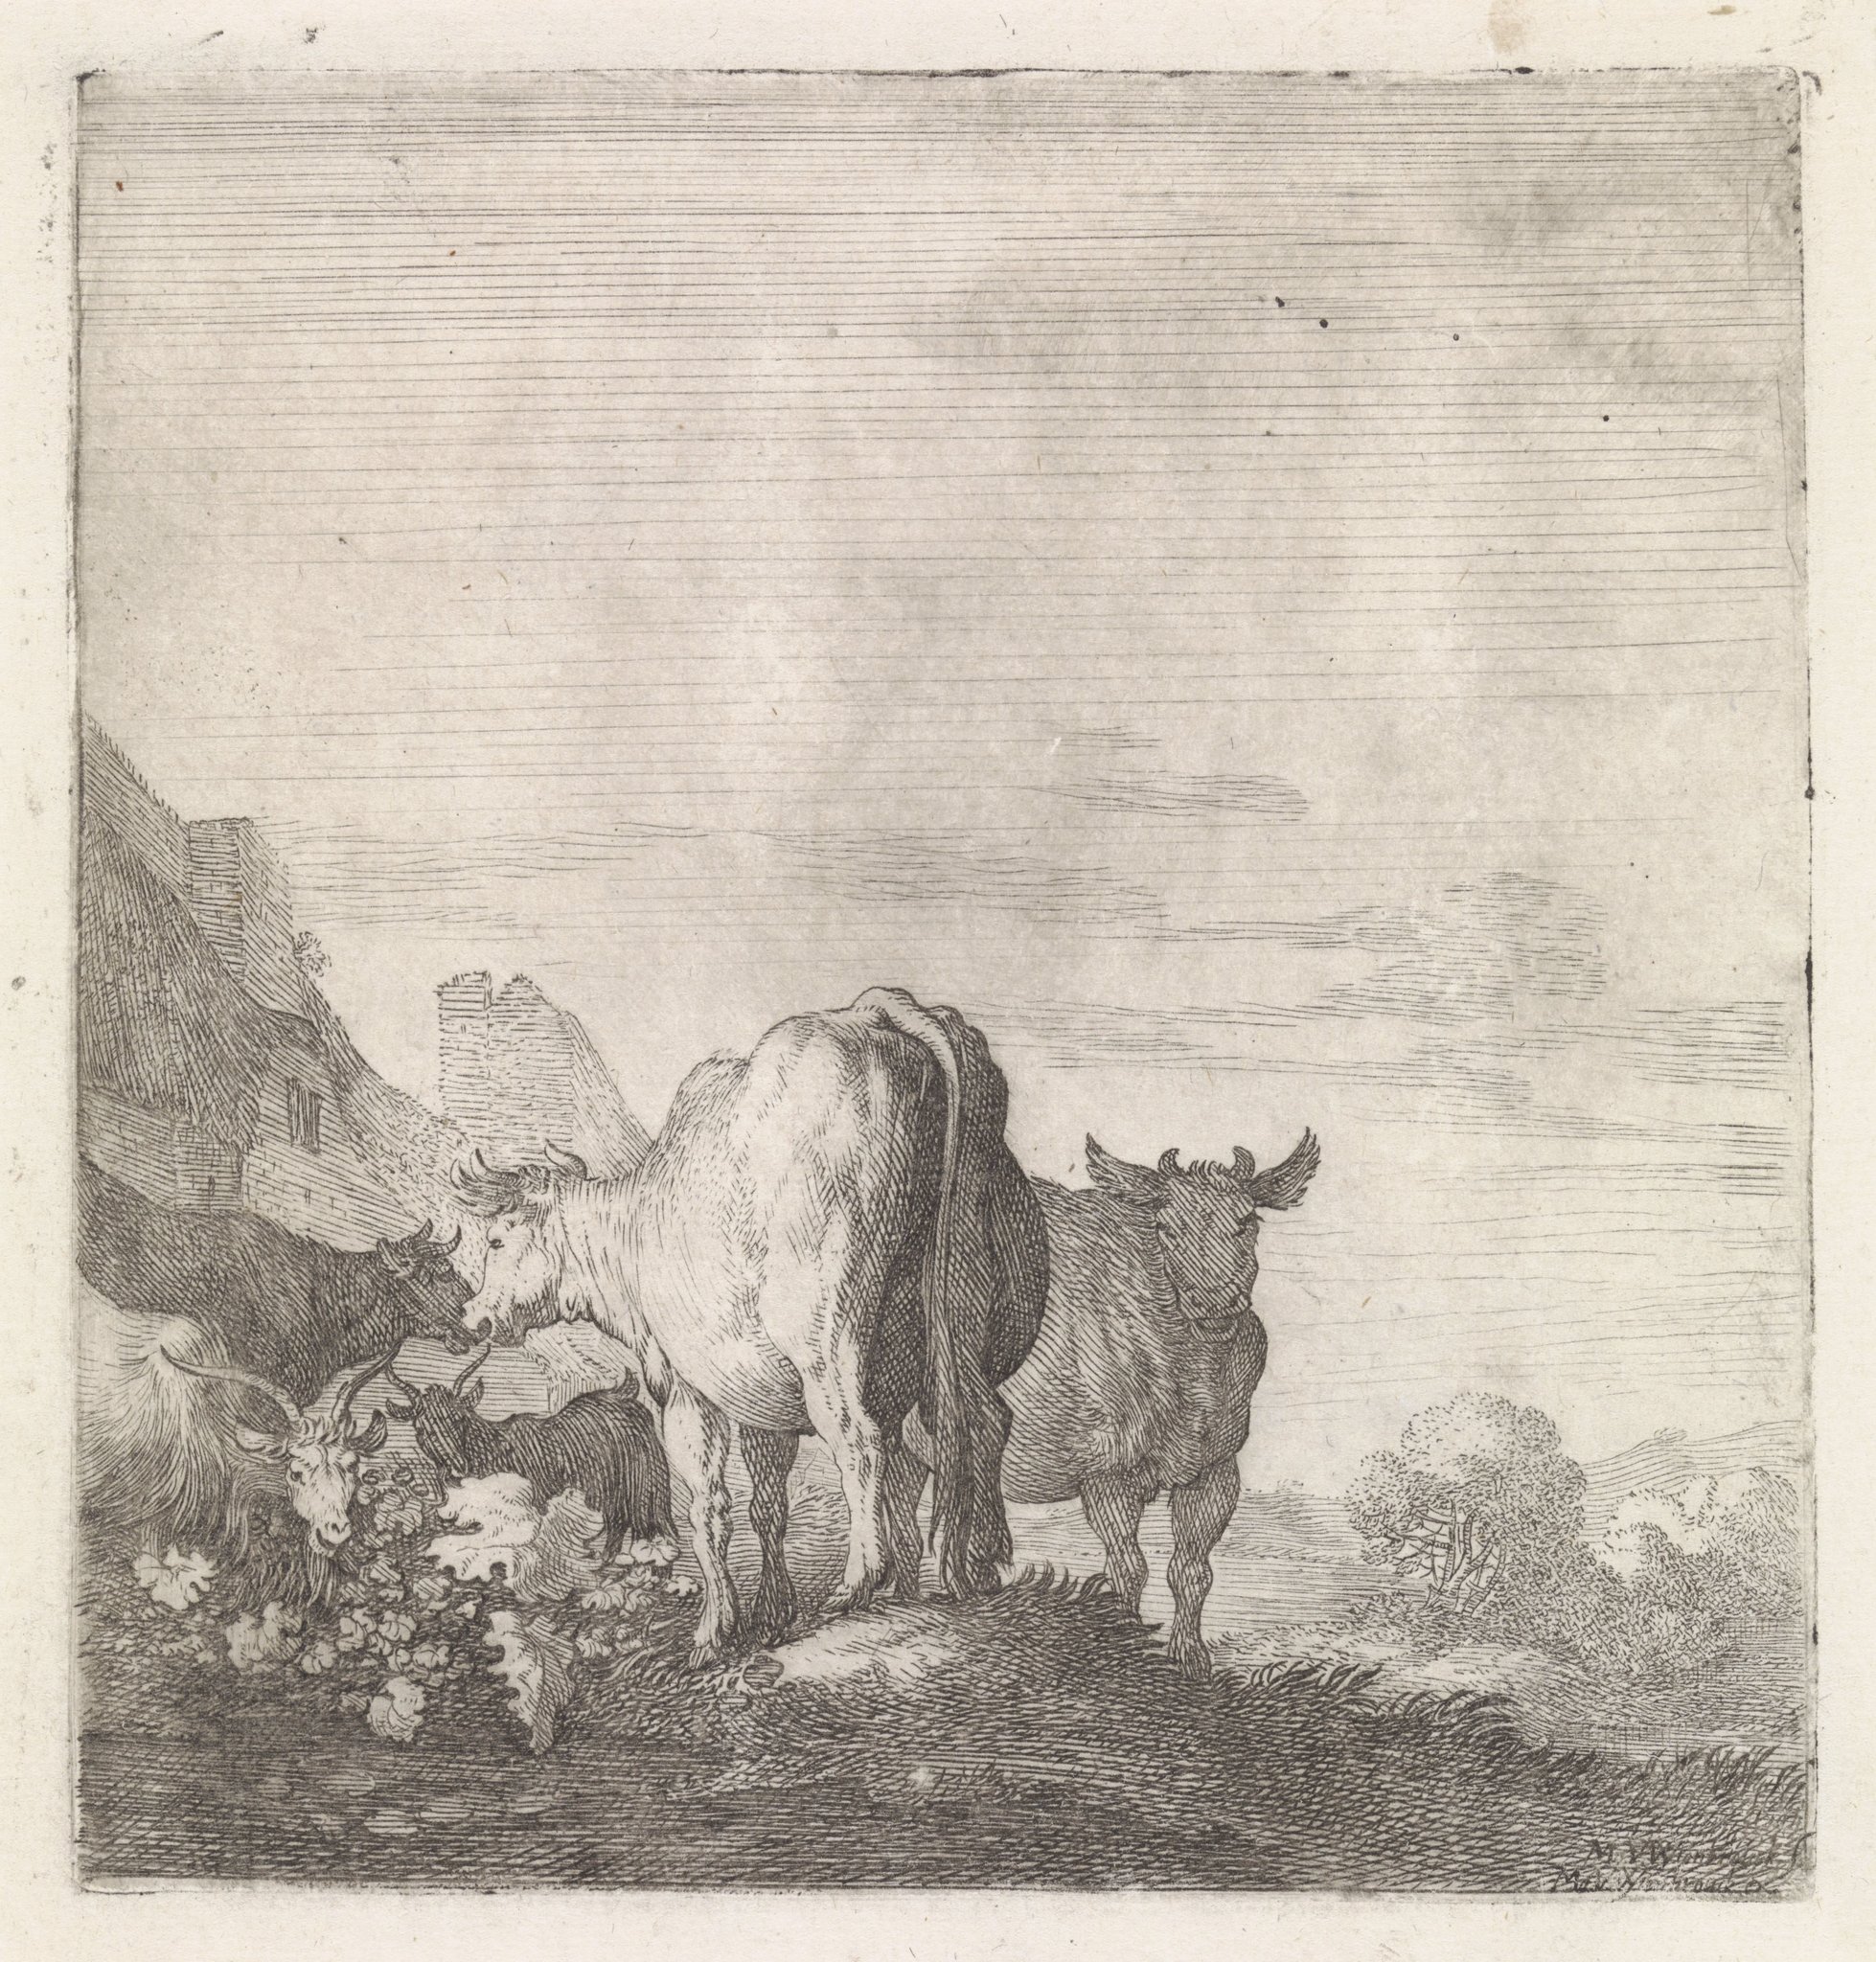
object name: print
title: Koeien en geiten in een landschap met huizen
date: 1600-1647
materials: paper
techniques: drypoint, engraving, etching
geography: the hague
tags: bovine cattle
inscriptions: collector's mark: Lugt 240